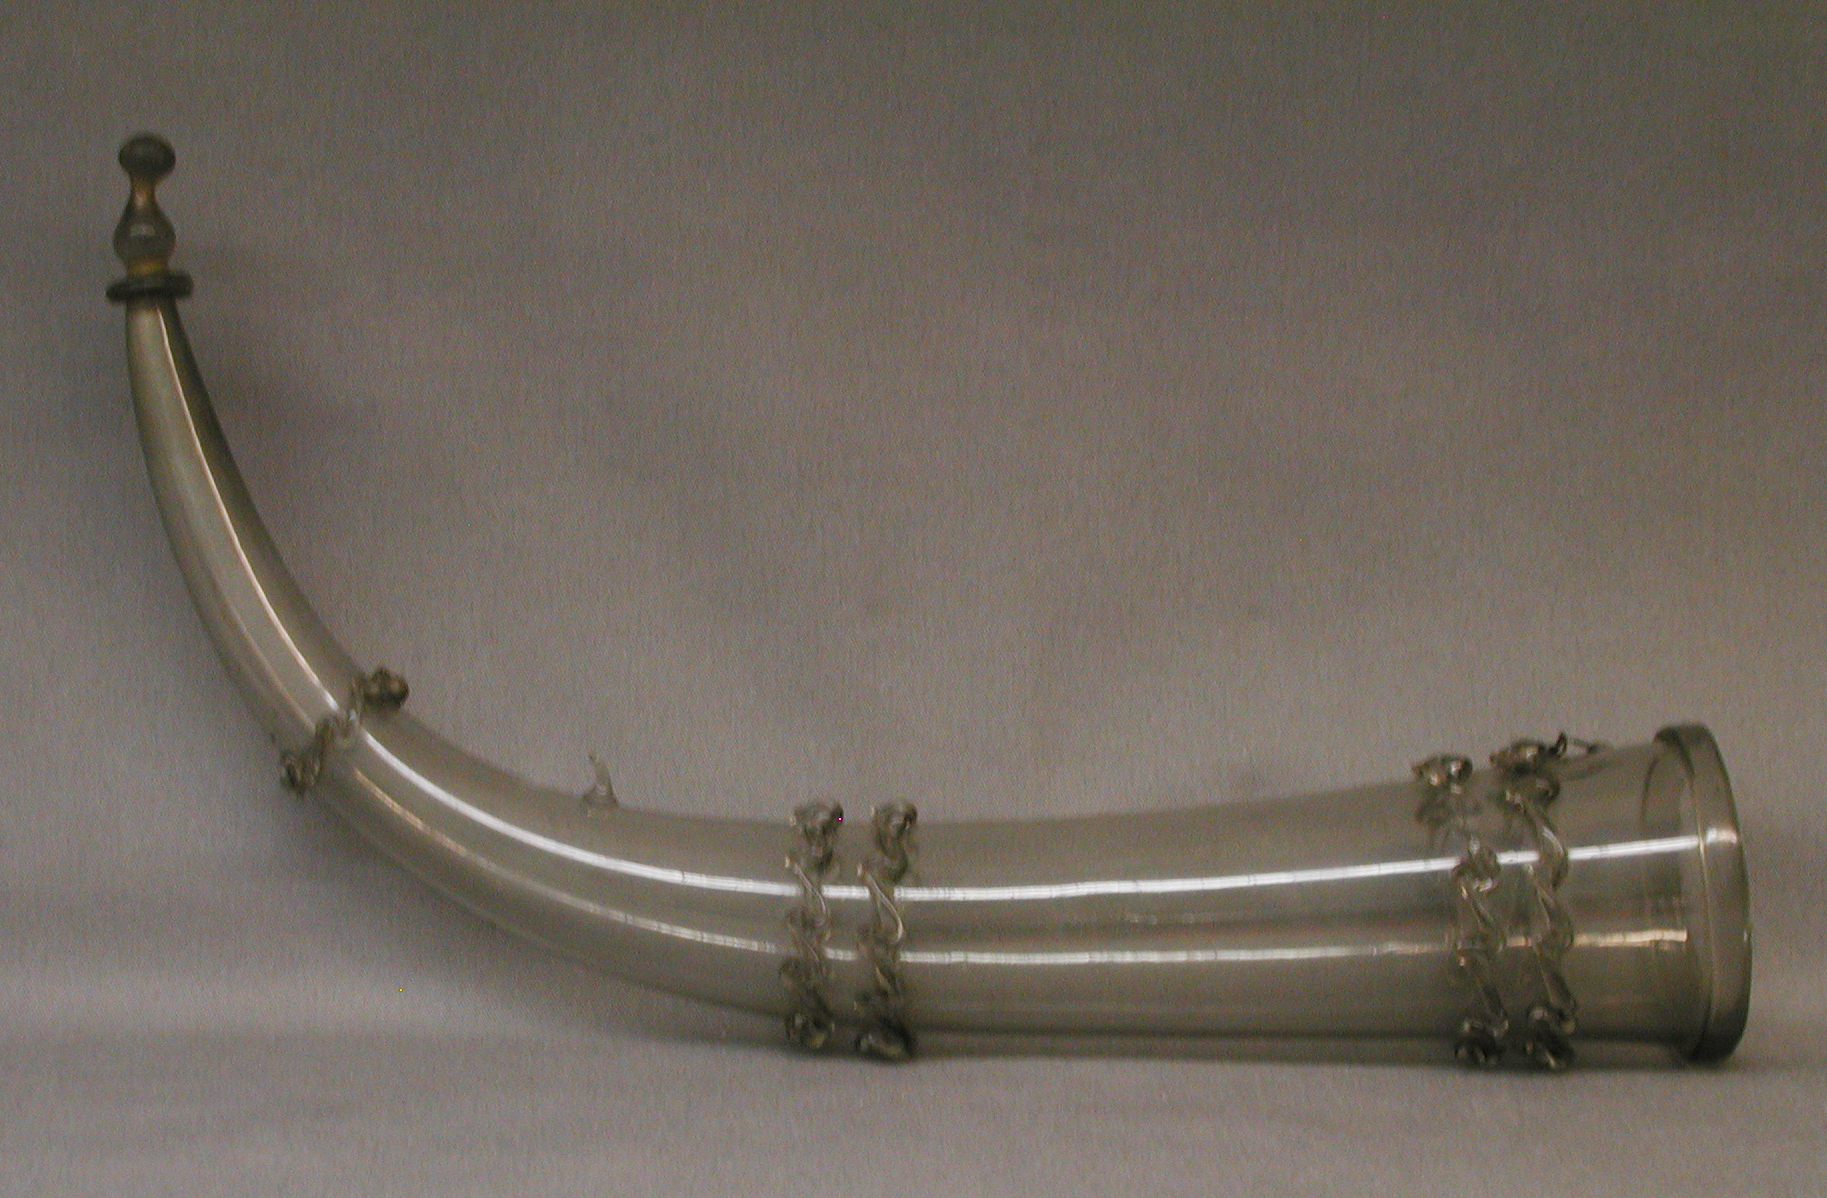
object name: horn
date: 1601-1700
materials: glass